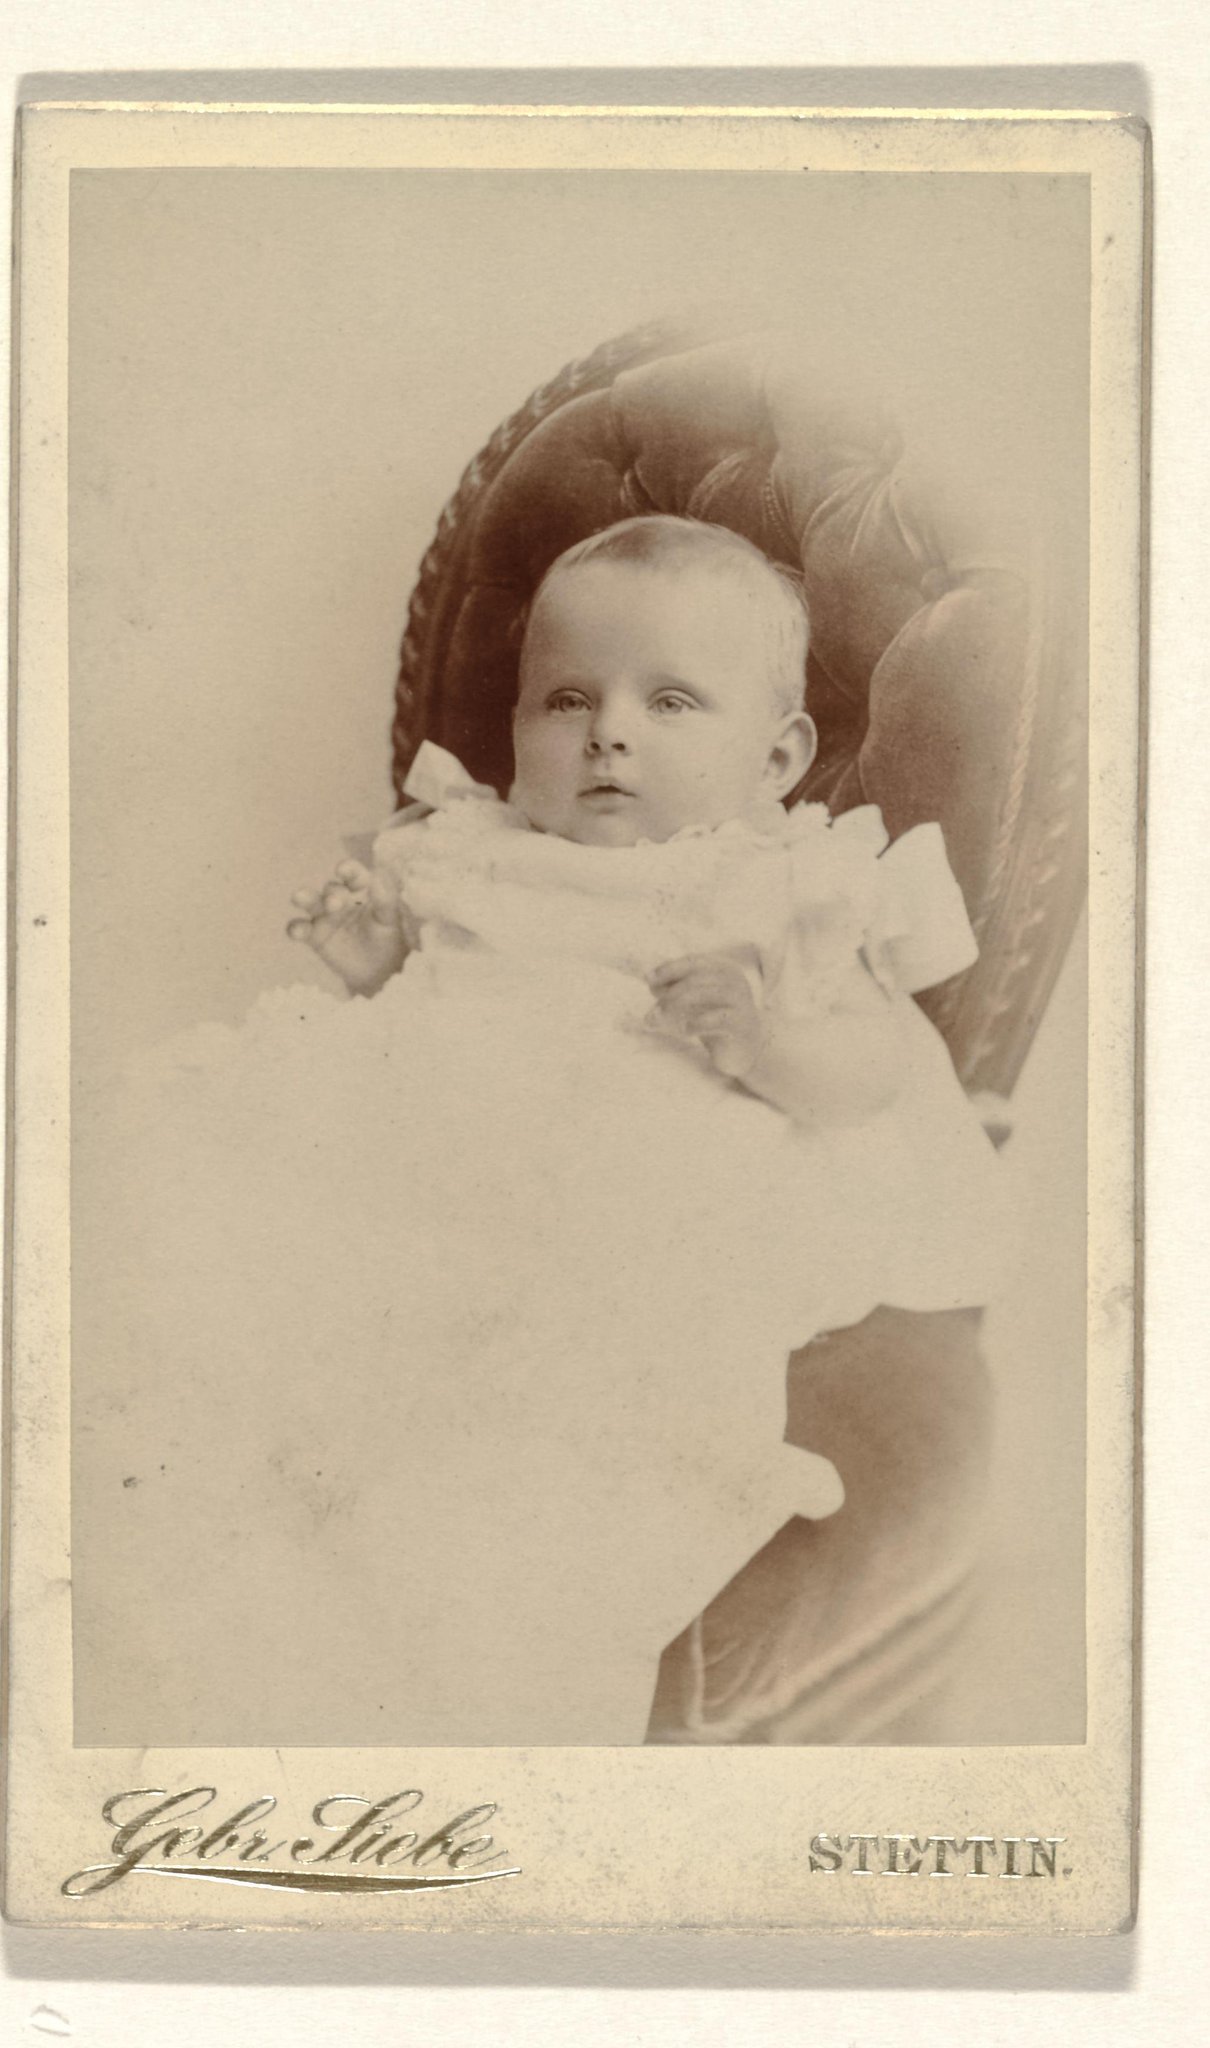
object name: photograph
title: Onbekende baby in jurk en liggend in een stoel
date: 1870-1900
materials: photographic support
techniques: gelatin silver print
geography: stettin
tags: stettin